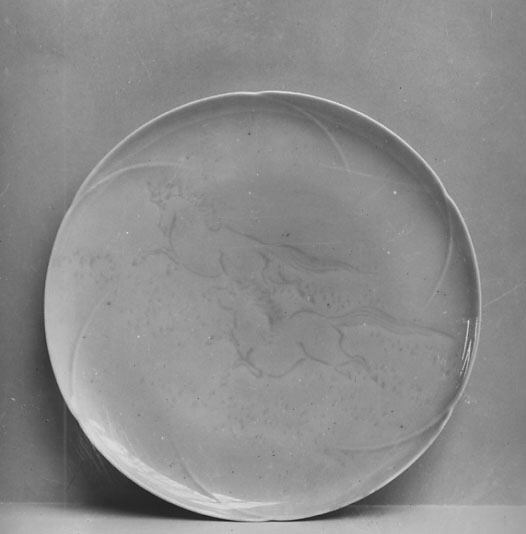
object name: plate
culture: french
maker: félix bracquemond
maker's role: artist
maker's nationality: french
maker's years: 1833-1914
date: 1875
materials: porcelain